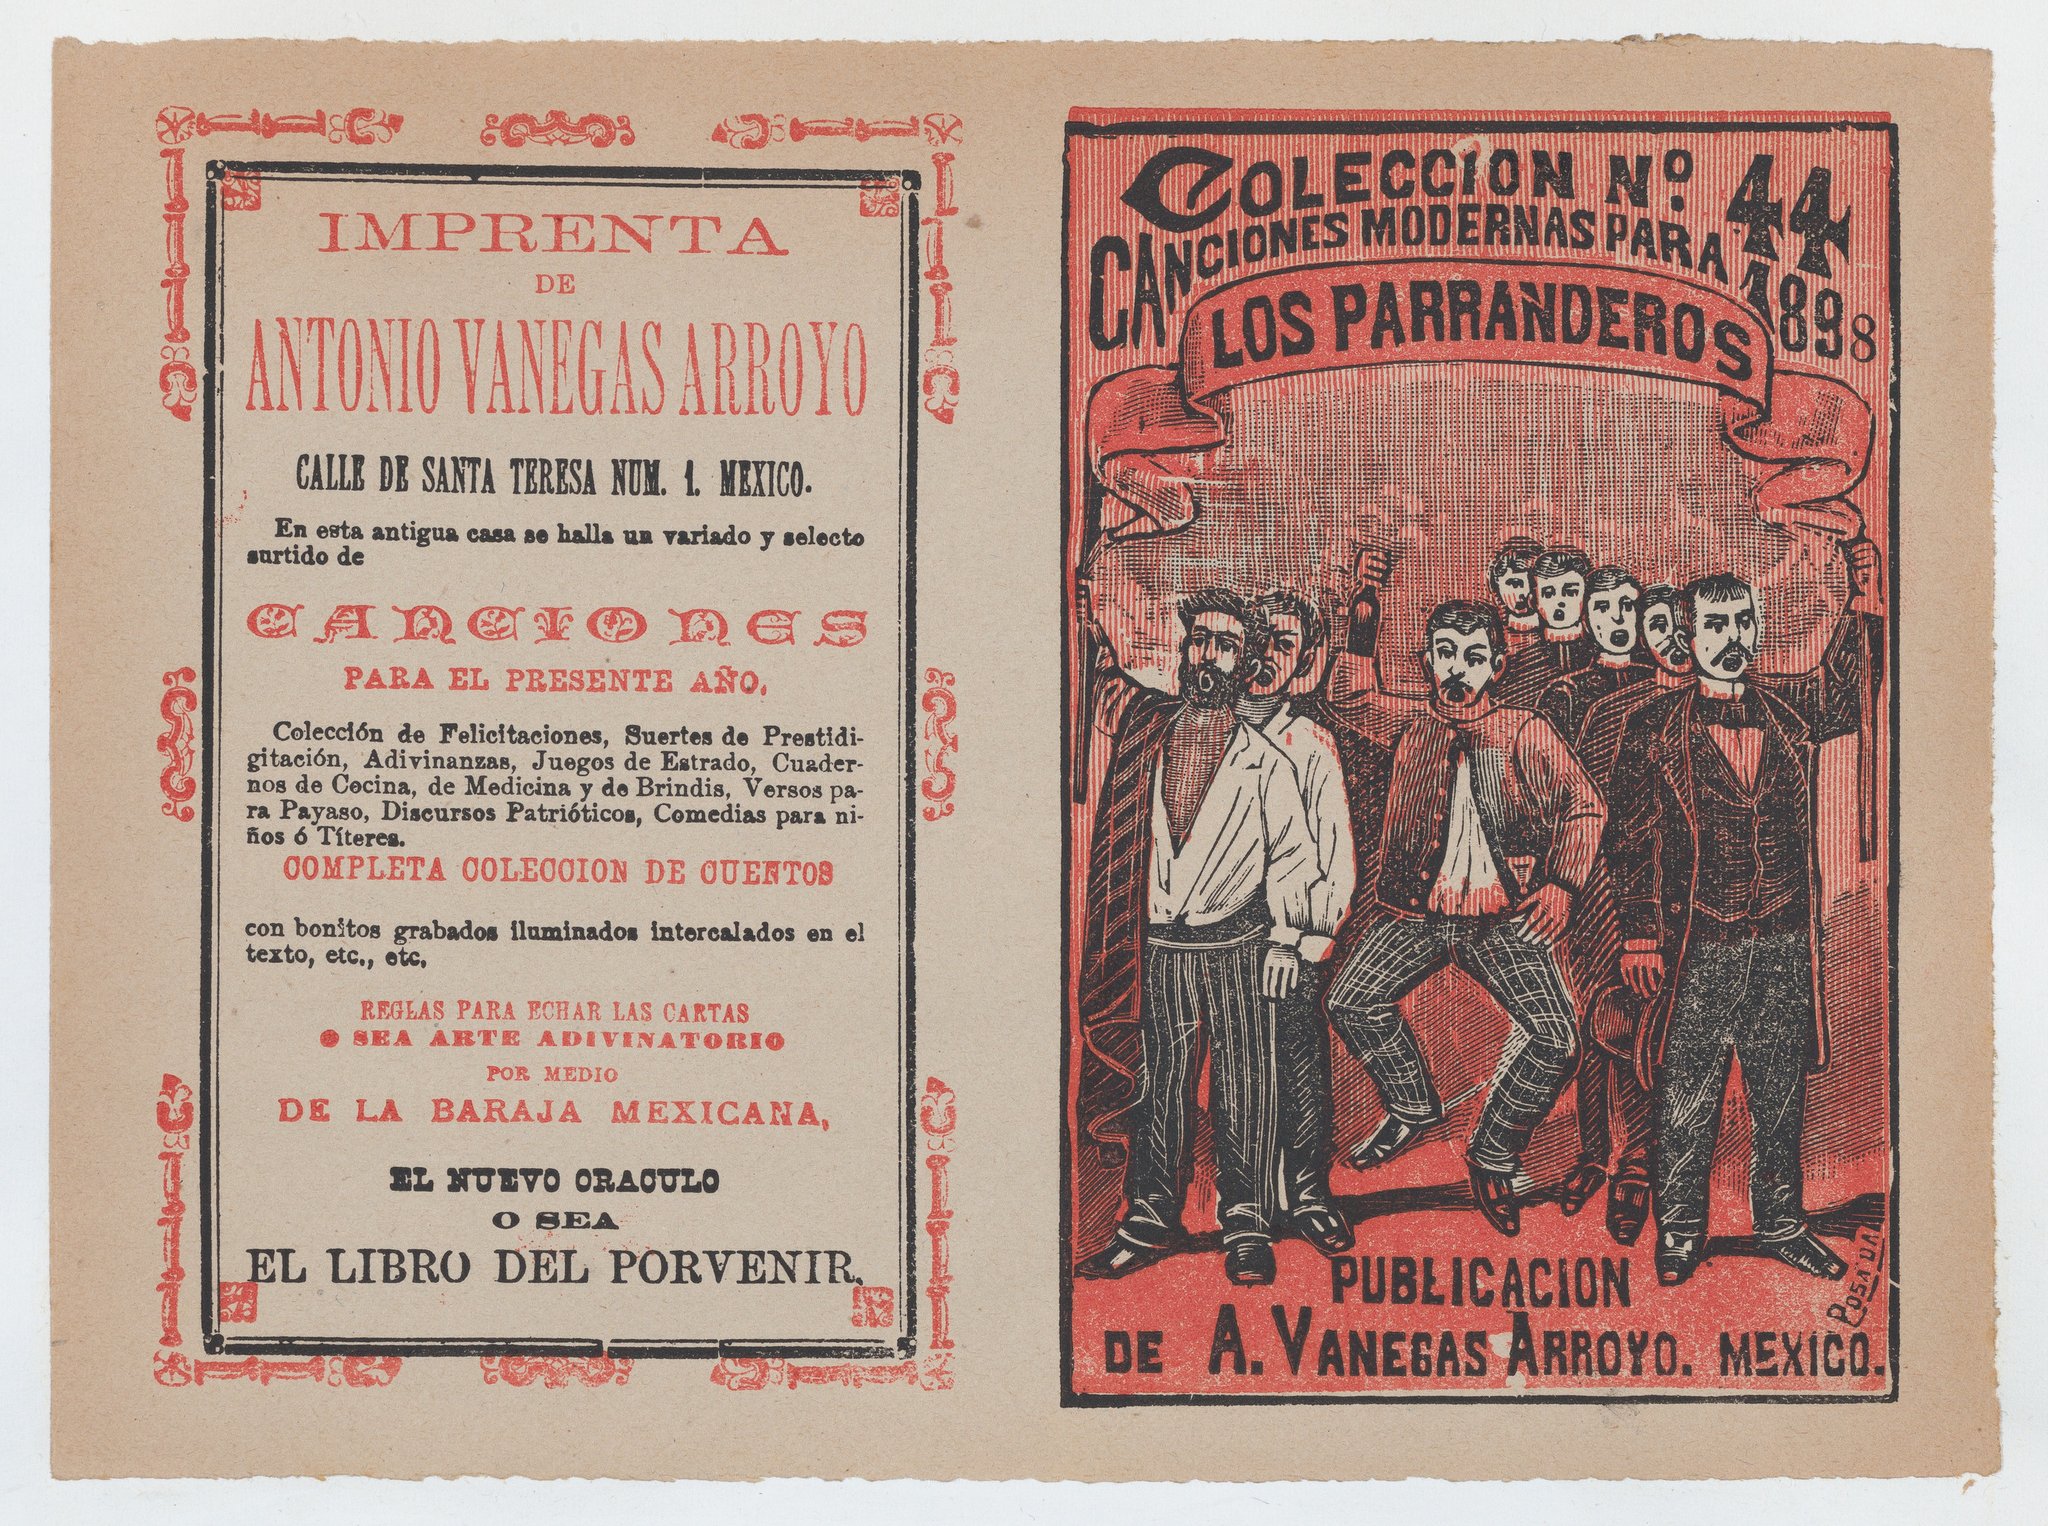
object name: print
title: Cover for 'Canciones Modernas para 1898: Los Parranderos', group of men holding a banner and singing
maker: josé guadalupe posada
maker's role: artist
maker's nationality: mexican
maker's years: 1852-1913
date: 1898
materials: metal, paper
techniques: engraving, letterpress, printing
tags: men,singing